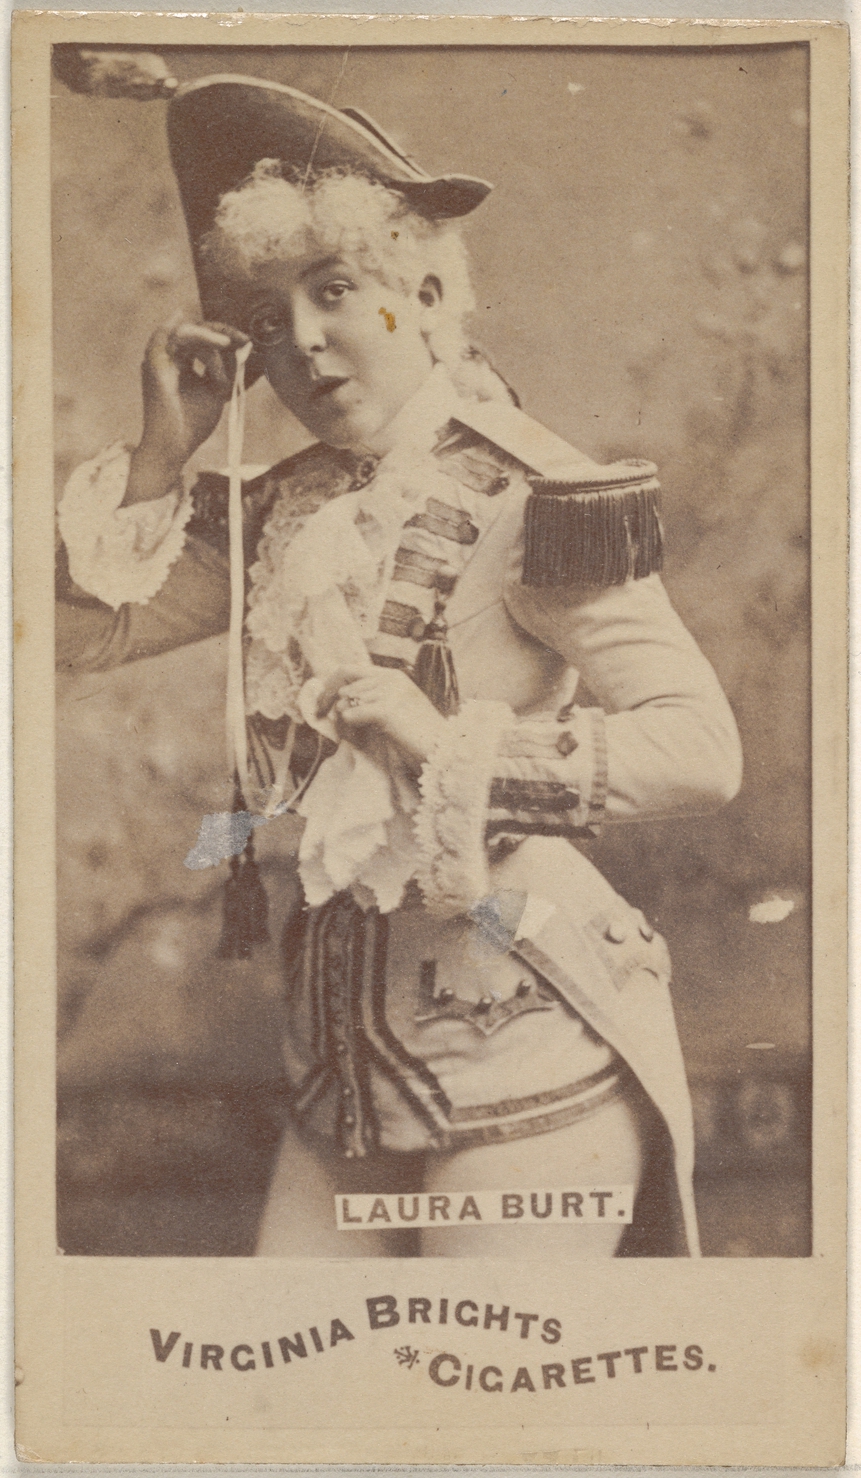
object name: photograph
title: Laura Burt, from the Actors and Actresses series (N45, Type 6) for Virginia Brights Cigarettes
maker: allen & ginter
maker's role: publisher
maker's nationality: american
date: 1888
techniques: albumen silver print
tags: portraits,women,actresses